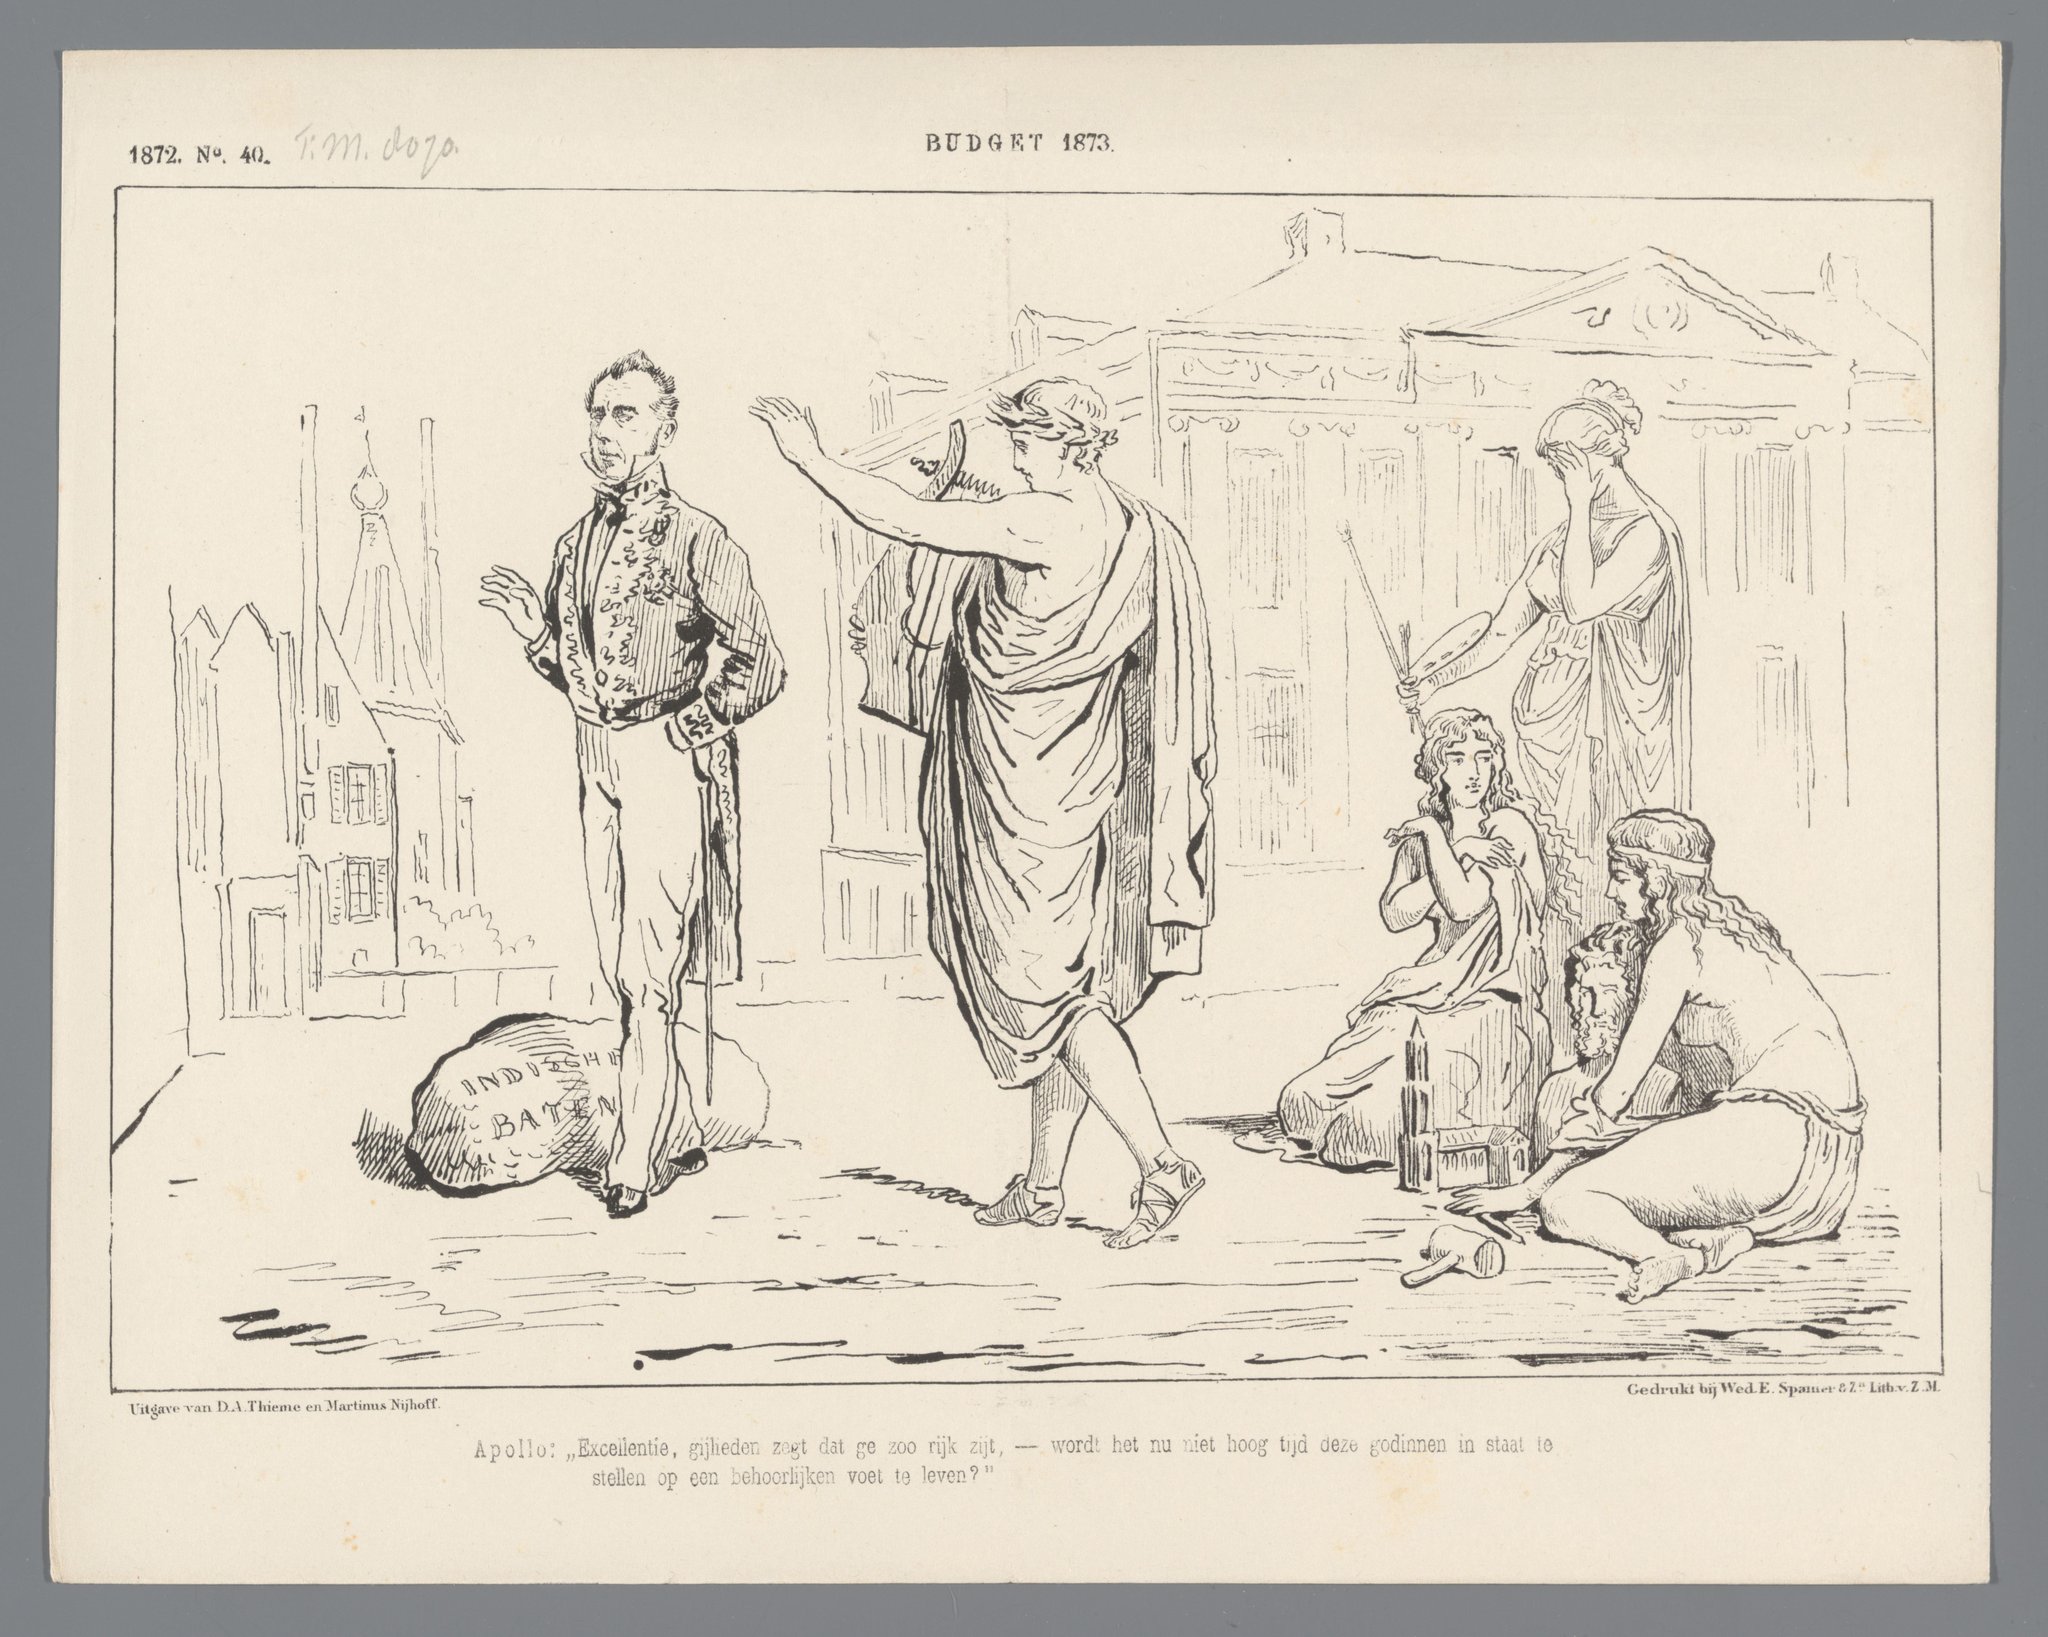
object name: cartoon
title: Spotprent over de begroting voor 1873, 1872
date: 1872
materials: paper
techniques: lithograph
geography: the hague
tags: apollo and the muses, apollo musagetes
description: Spotprent op minister Geertsema en de begroting voor het jaar 1873. Apollo en de muzen smeken de minister om steun voor de kunsten. Plaat verschenen bij het weekblad De Nederlandsche Spectator, nr. 40, 1872.